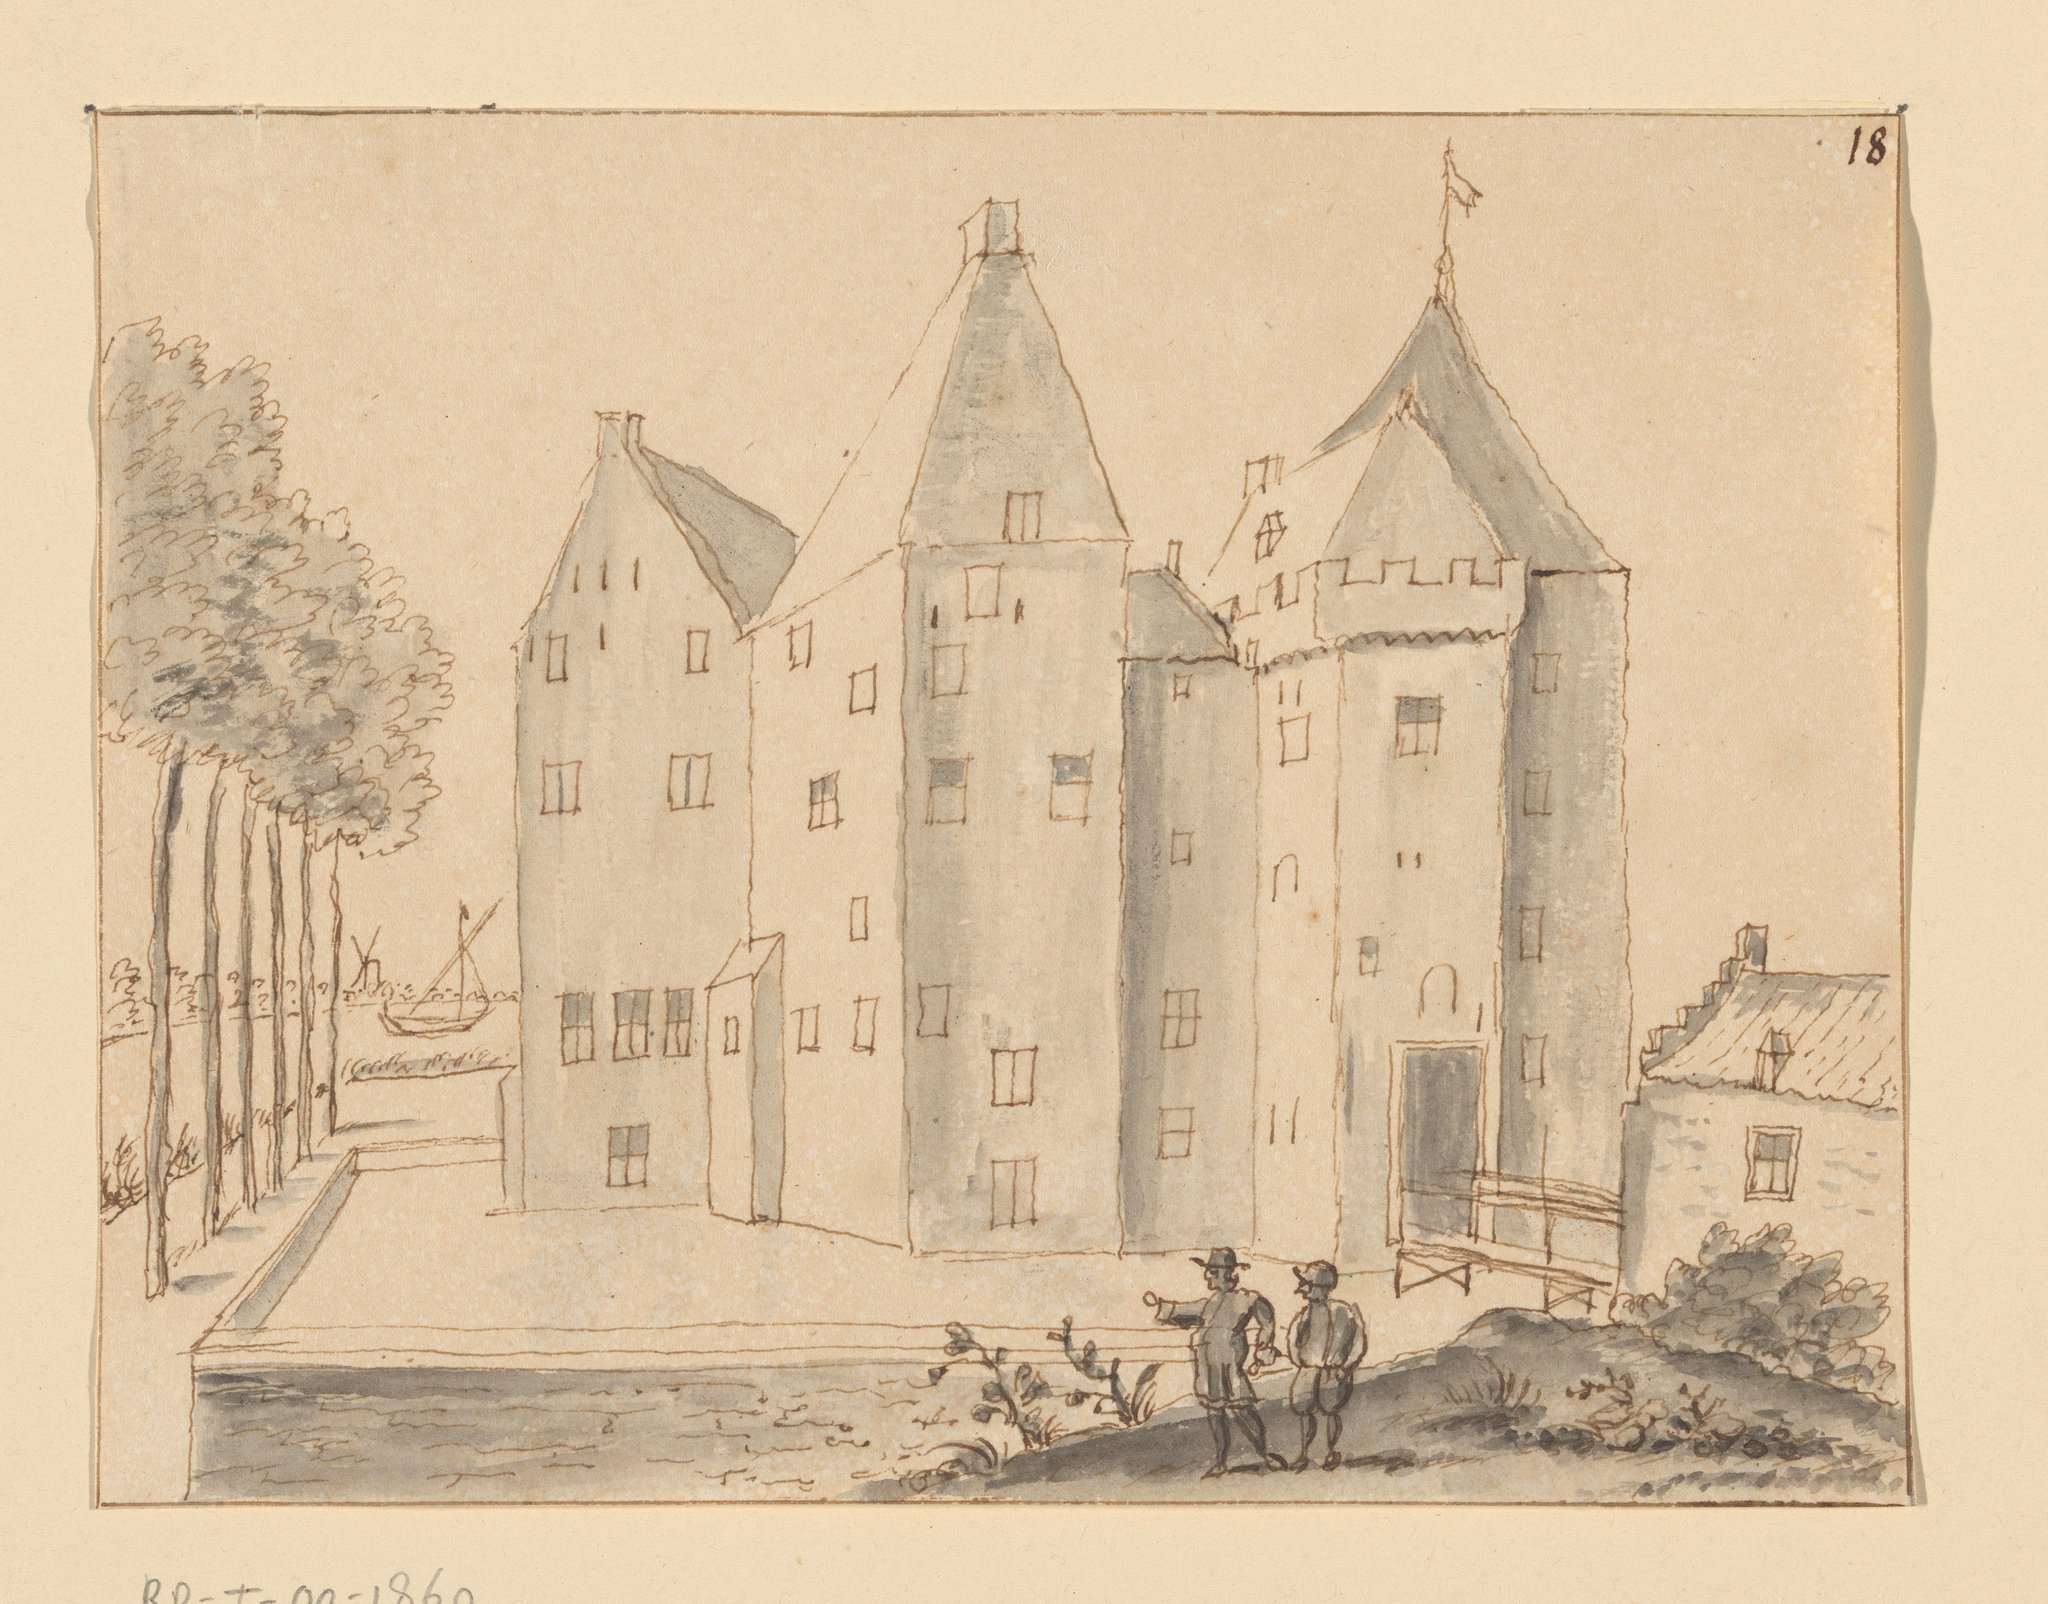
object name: drawing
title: Gezicht op een kasteel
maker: Anonymous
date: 1699-1749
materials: ink, paper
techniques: brush, pen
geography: netherlands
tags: castle, netherlands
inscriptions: number: ‘18’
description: Deze tekening hoort waarschijnlijk bij de groep topografische tekeningen die eerder werd toegeschreven aan Hendrik Pola.